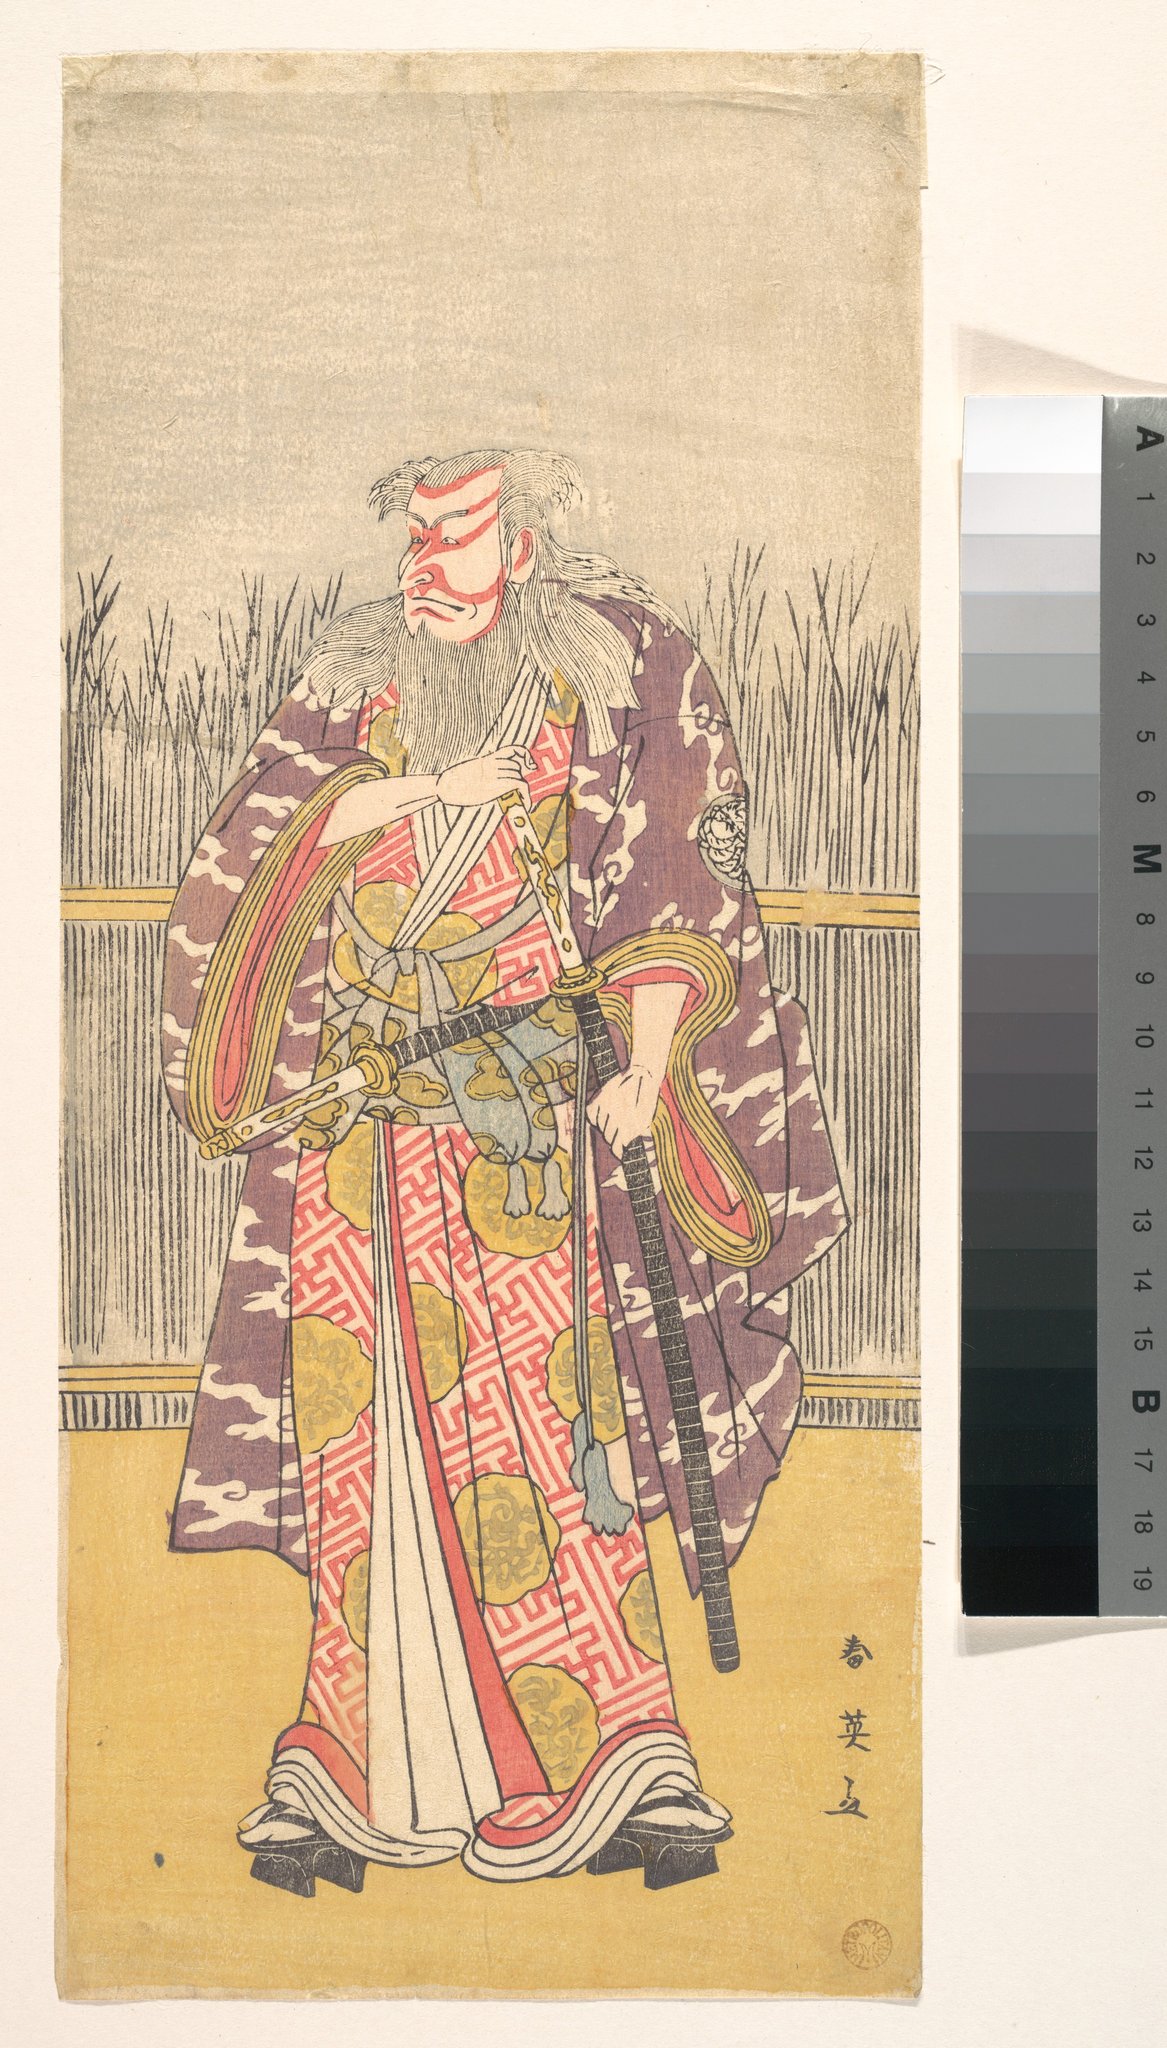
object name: woodblock print nishiki e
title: The Actor Ichikawa Ebizō (Danjūrō V) as the Elderly Samurai Sasaki Ganryū (?)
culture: japanese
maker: katsukawa shun'ei 勝川春英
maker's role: artist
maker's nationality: japanese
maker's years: 1762-1819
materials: ink, paper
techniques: nishiki e, woodblock print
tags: swords,actors